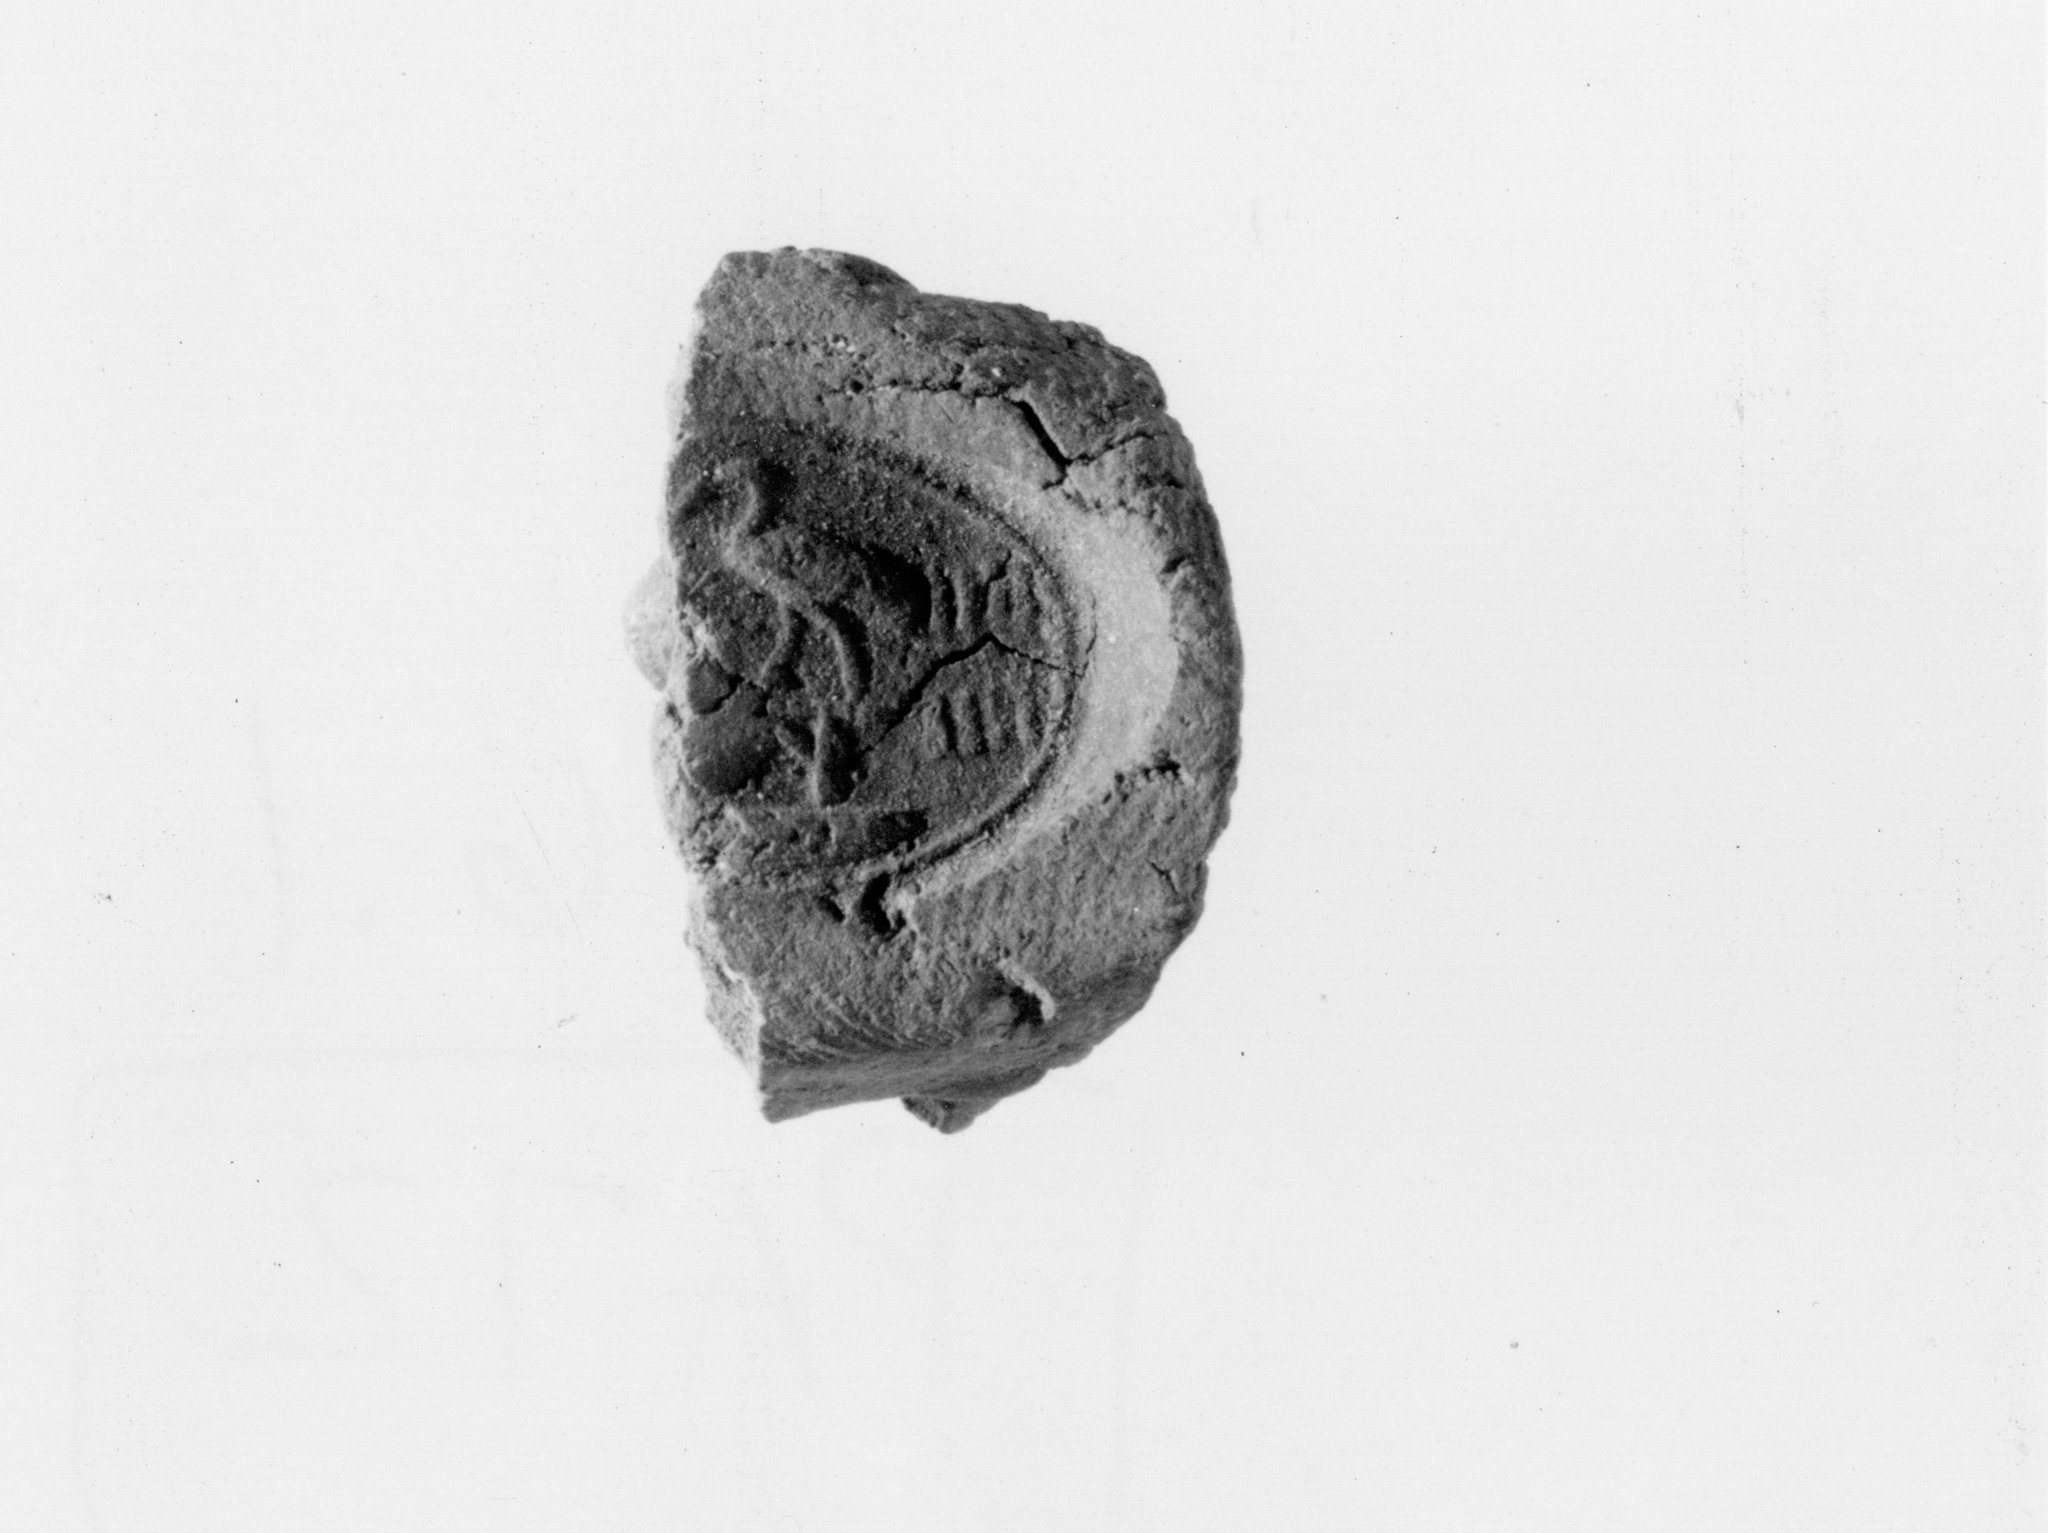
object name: sealing, nebmaatre, amenhotep iii, heb sed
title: Document Sealing With the Throne Name of Amenhotep III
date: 1390-1352 BCE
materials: mud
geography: egypt